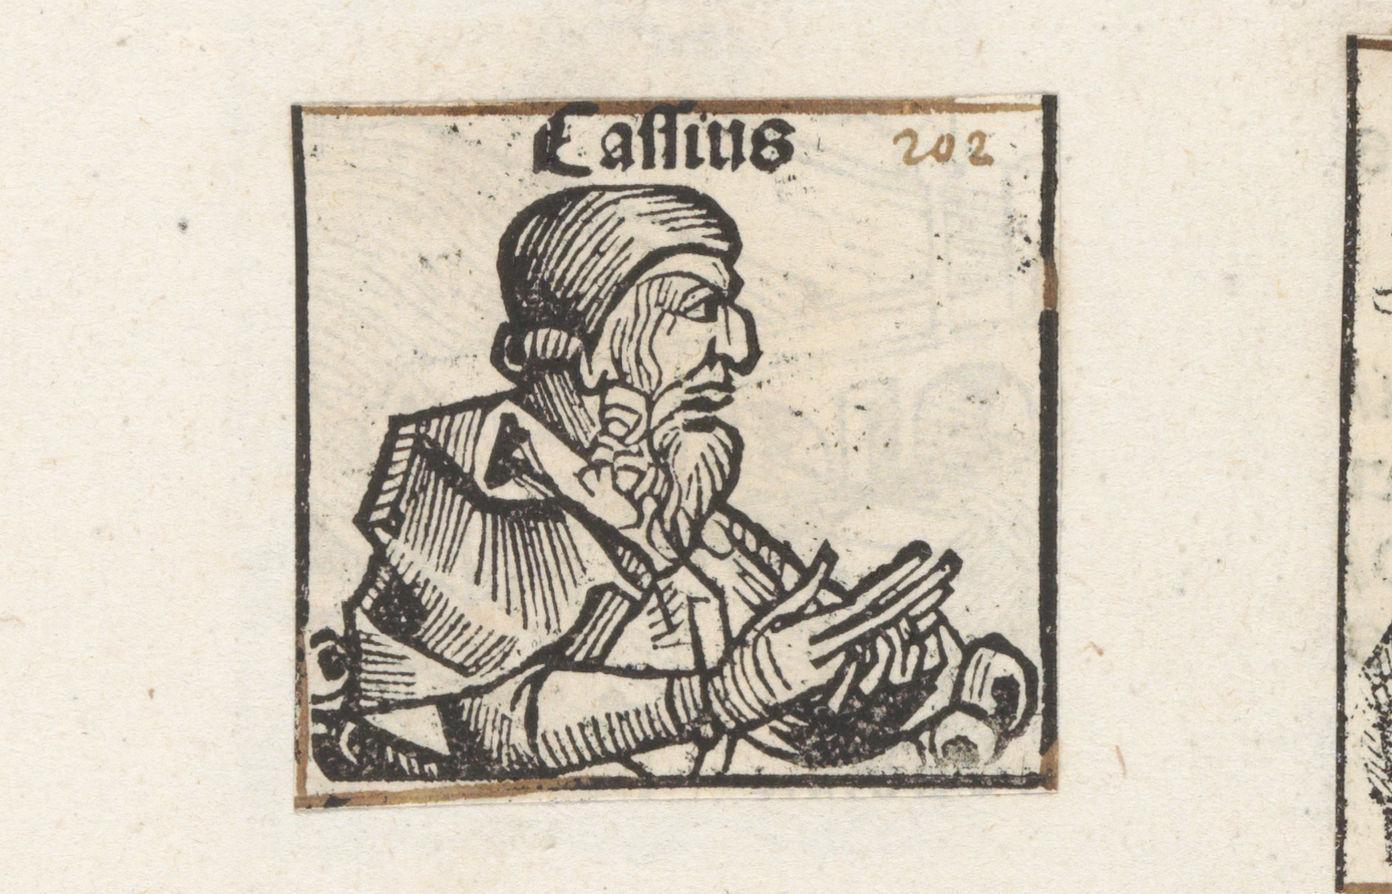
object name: print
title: Liber Chronicarum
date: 1493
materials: paper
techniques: letterpress printing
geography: nuremberg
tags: male persons from classical history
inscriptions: inscription: ‘202’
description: De houtsnede wordt gebruikt als boekillustratie in de Liber Chronicarum (of Neurenbergkroniek) van Hartmann Schedel, verschenen in het Latijn en Duits in 1493. Zie de Latijnse uitgave, folio 87v.